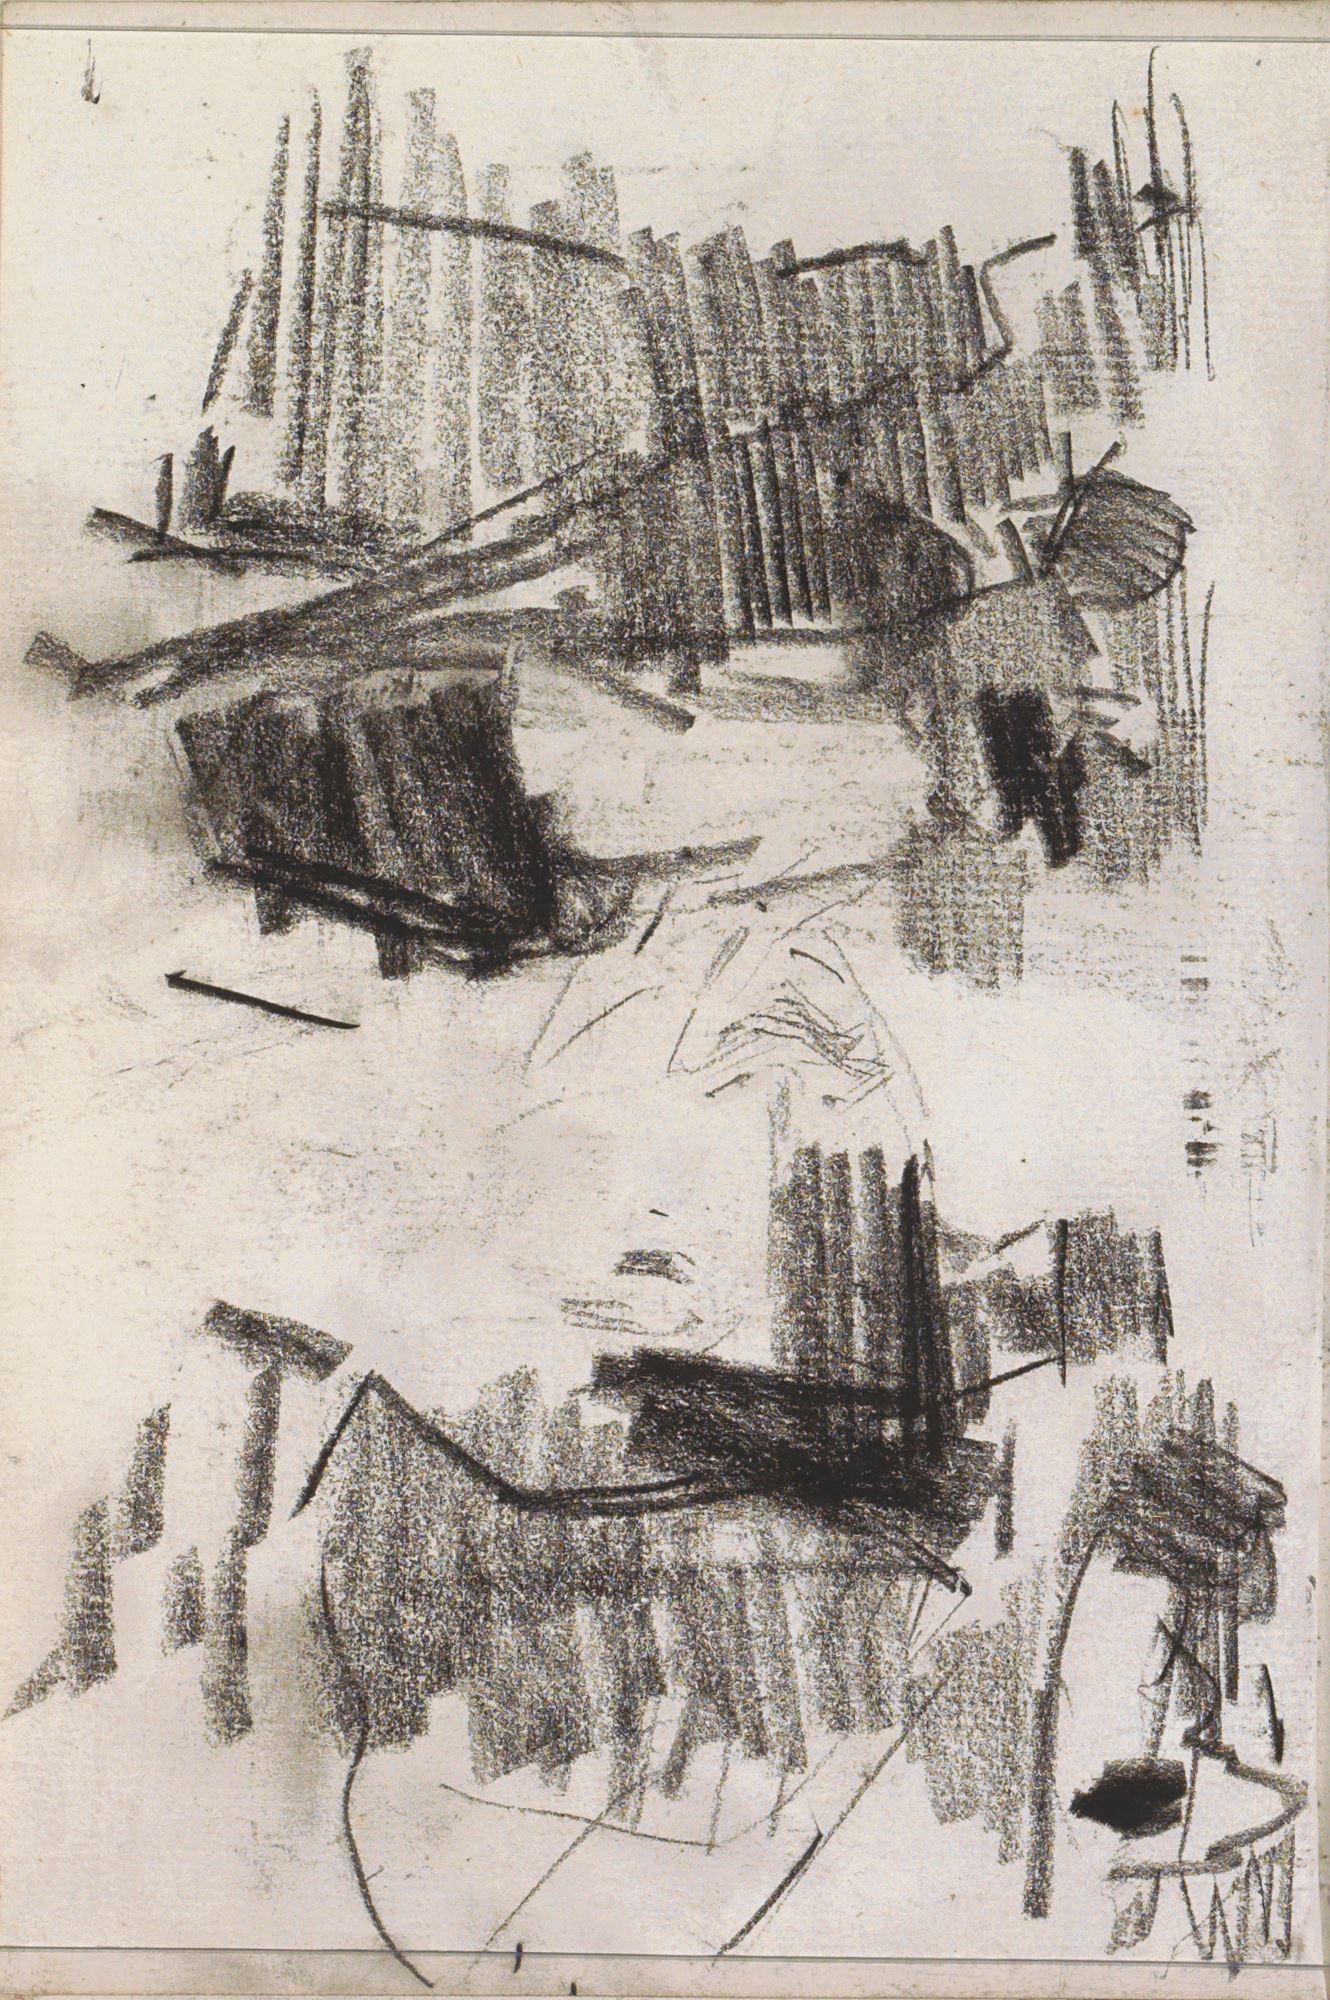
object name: sketchbook leaf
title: Vrouwenhoofd en drie wandelende vrouwen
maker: isaac israels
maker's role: draughtsman, painter, print maker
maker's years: 1865-1934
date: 1875-1934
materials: chalk, paper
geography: the hague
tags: adult woman (+ three persons), head (human) - aa - female human figure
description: Pagina 11 uit schetsboek XLIV met 43 pagina's.